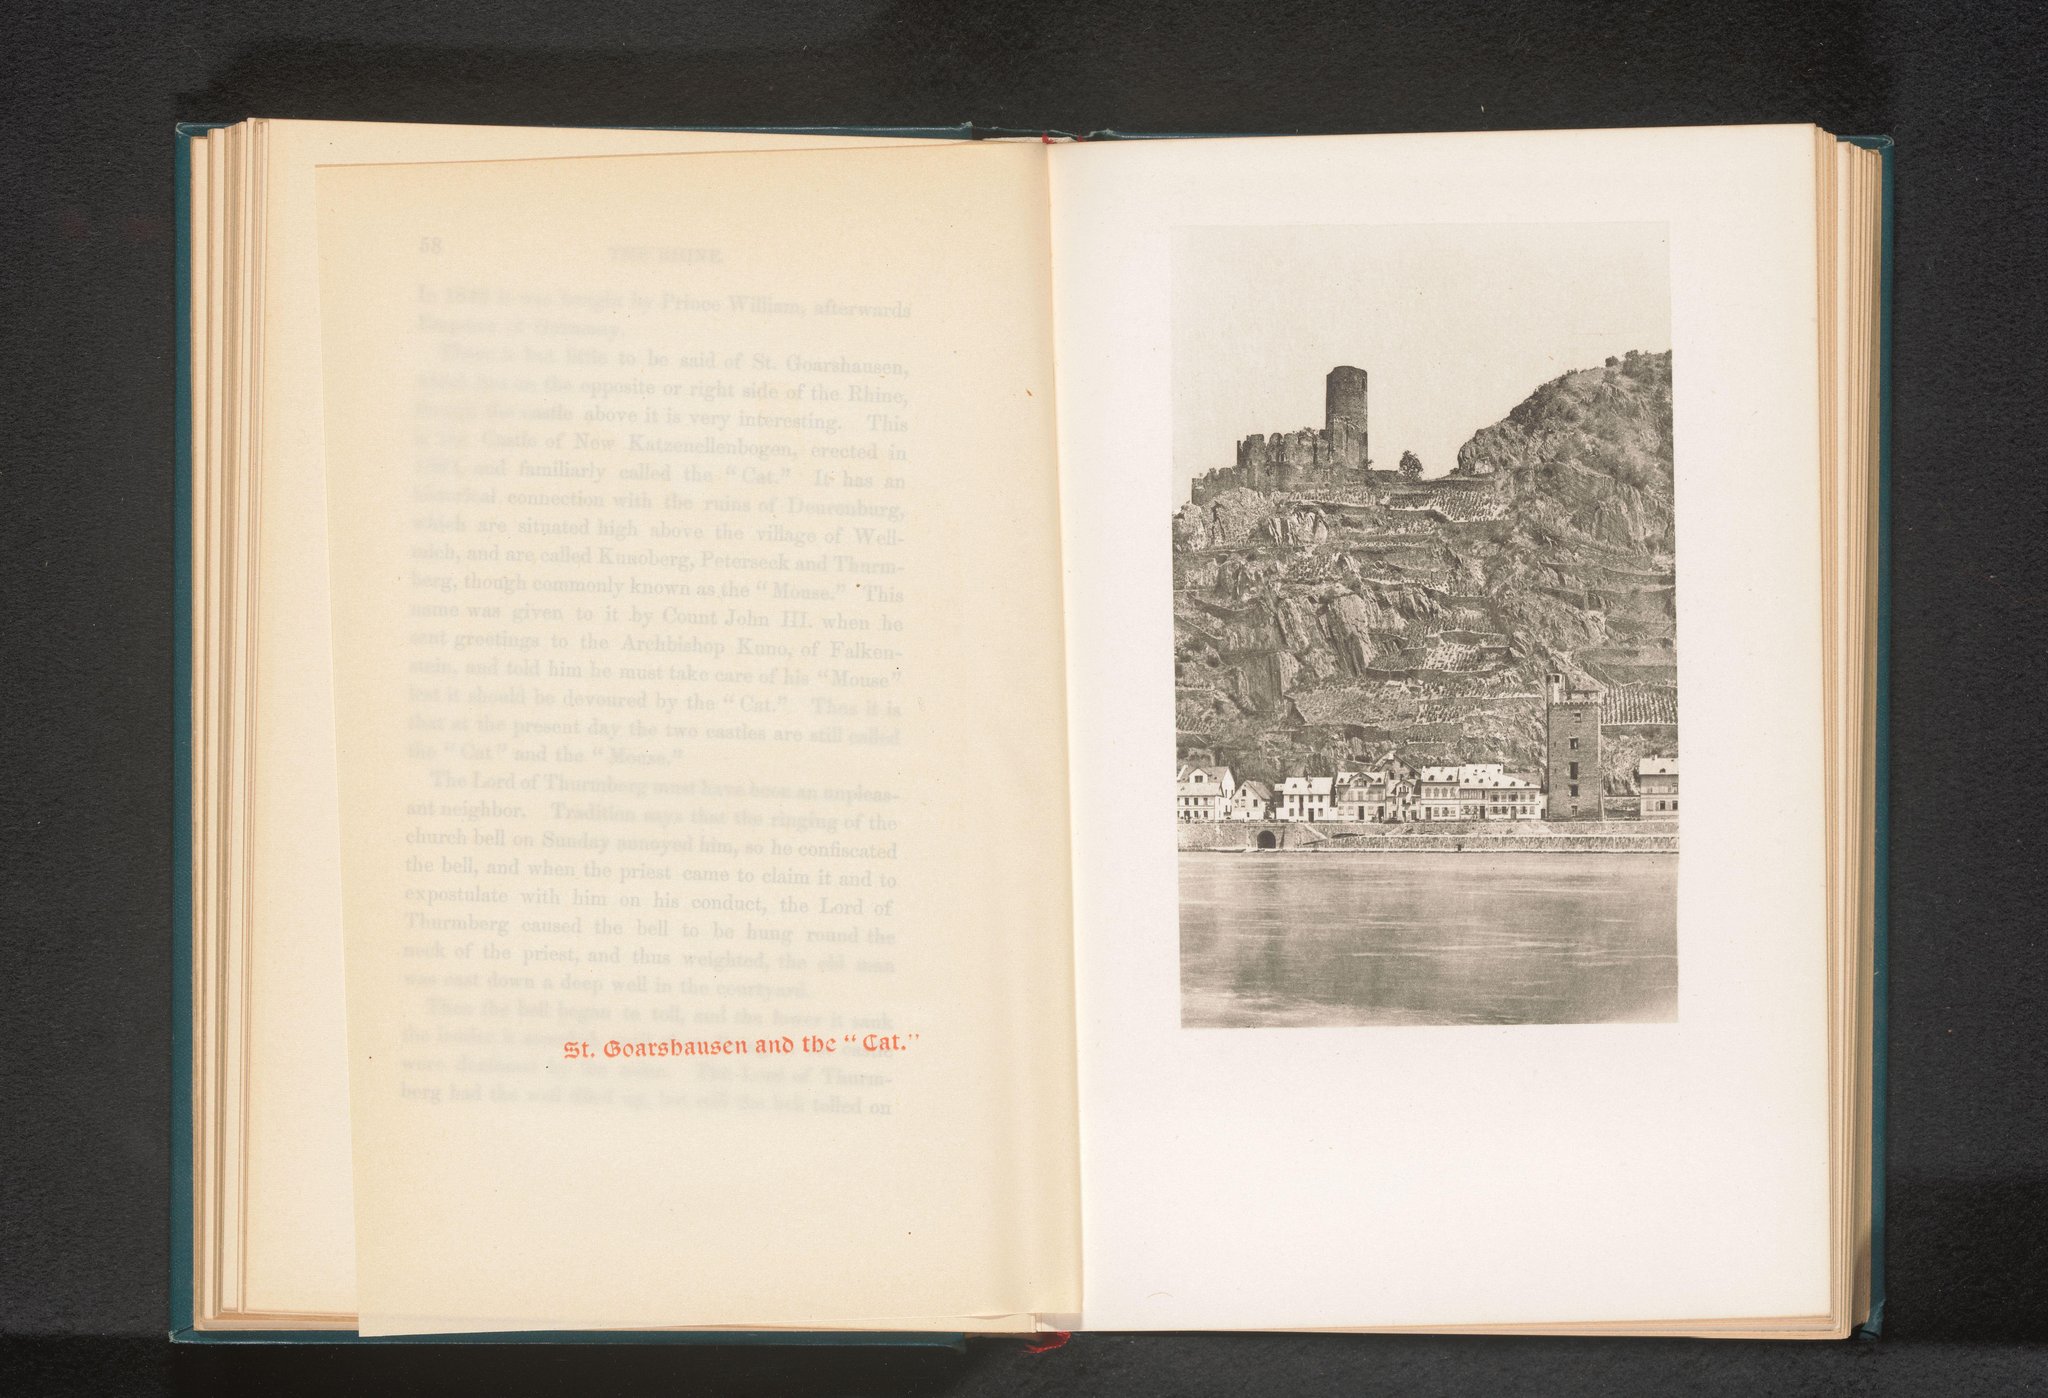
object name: page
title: Gezicht op Sankt Goarshausen en Burcht Katz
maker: Anonymous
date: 1889-1899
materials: paper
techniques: photoaquatint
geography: rhineland-palatinate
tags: city-view in general; 'veduta', castle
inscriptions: title: ‘St. Goarshausen and the "Cat."’